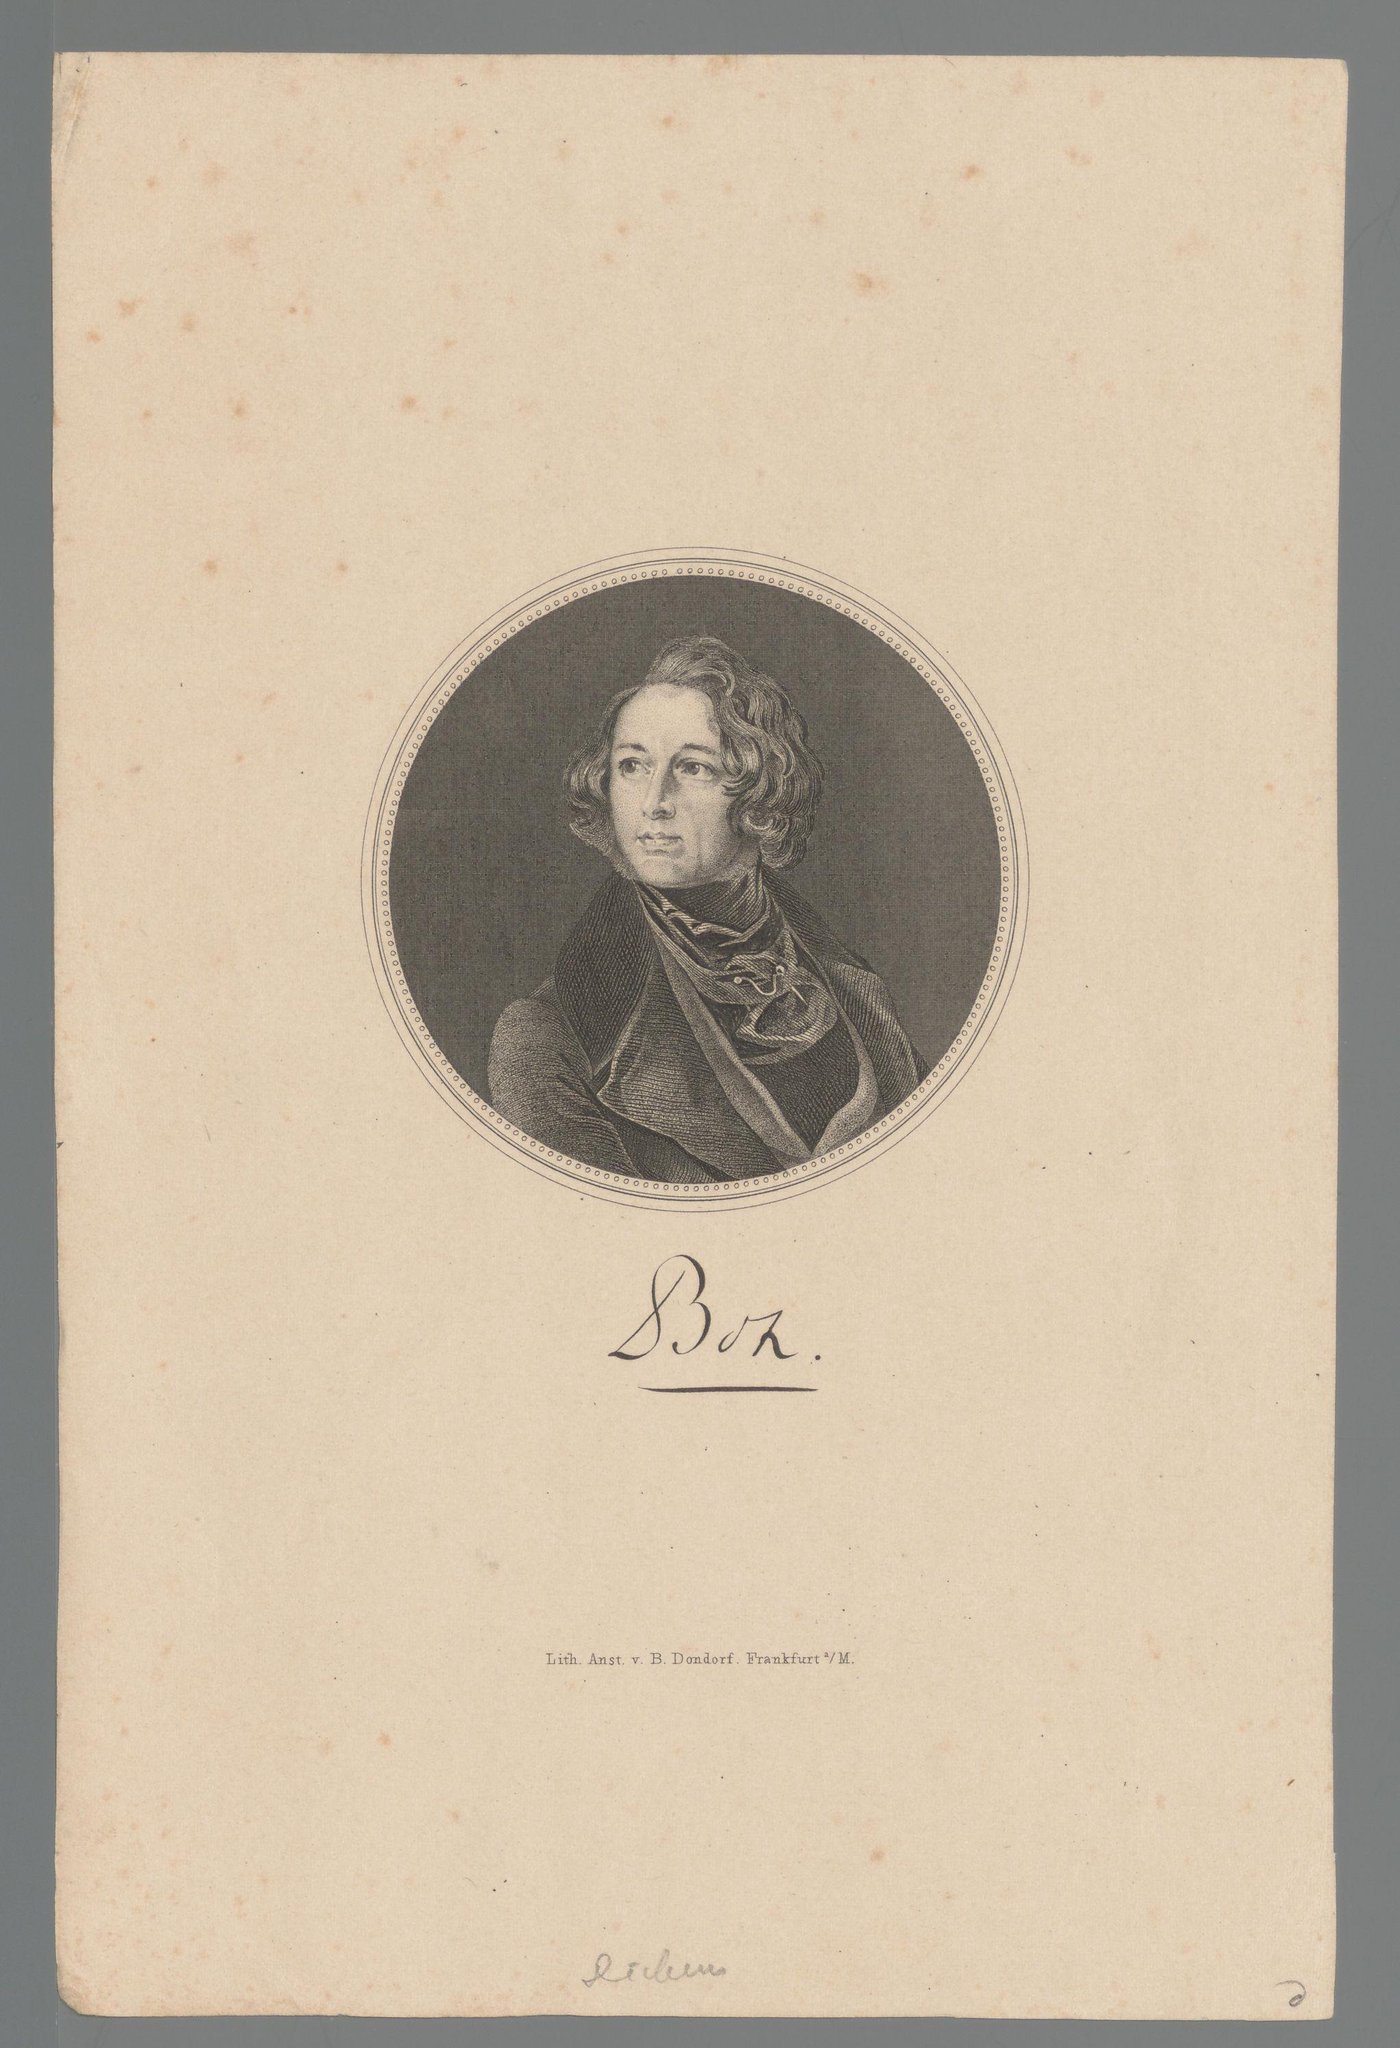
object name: print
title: Portret van Charles Dickens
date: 1835-1910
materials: paper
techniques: lithograph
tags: portsmouth, adult man, historical persons, portrait of a writer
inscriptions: collector's mark: Lugt 2228